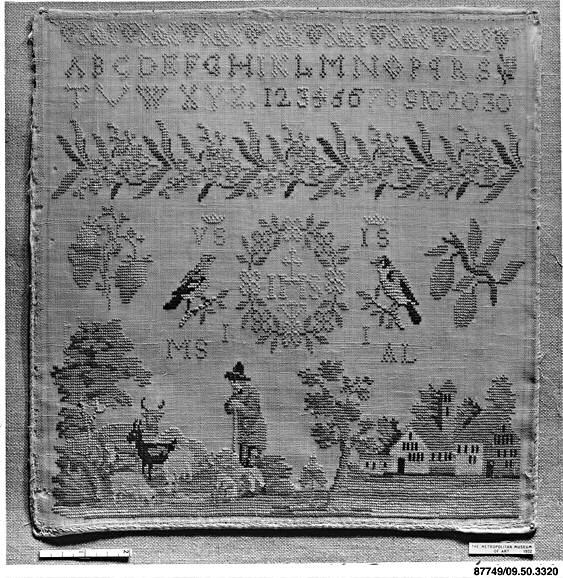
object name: sampler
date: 1801-1850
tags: human figures,birds